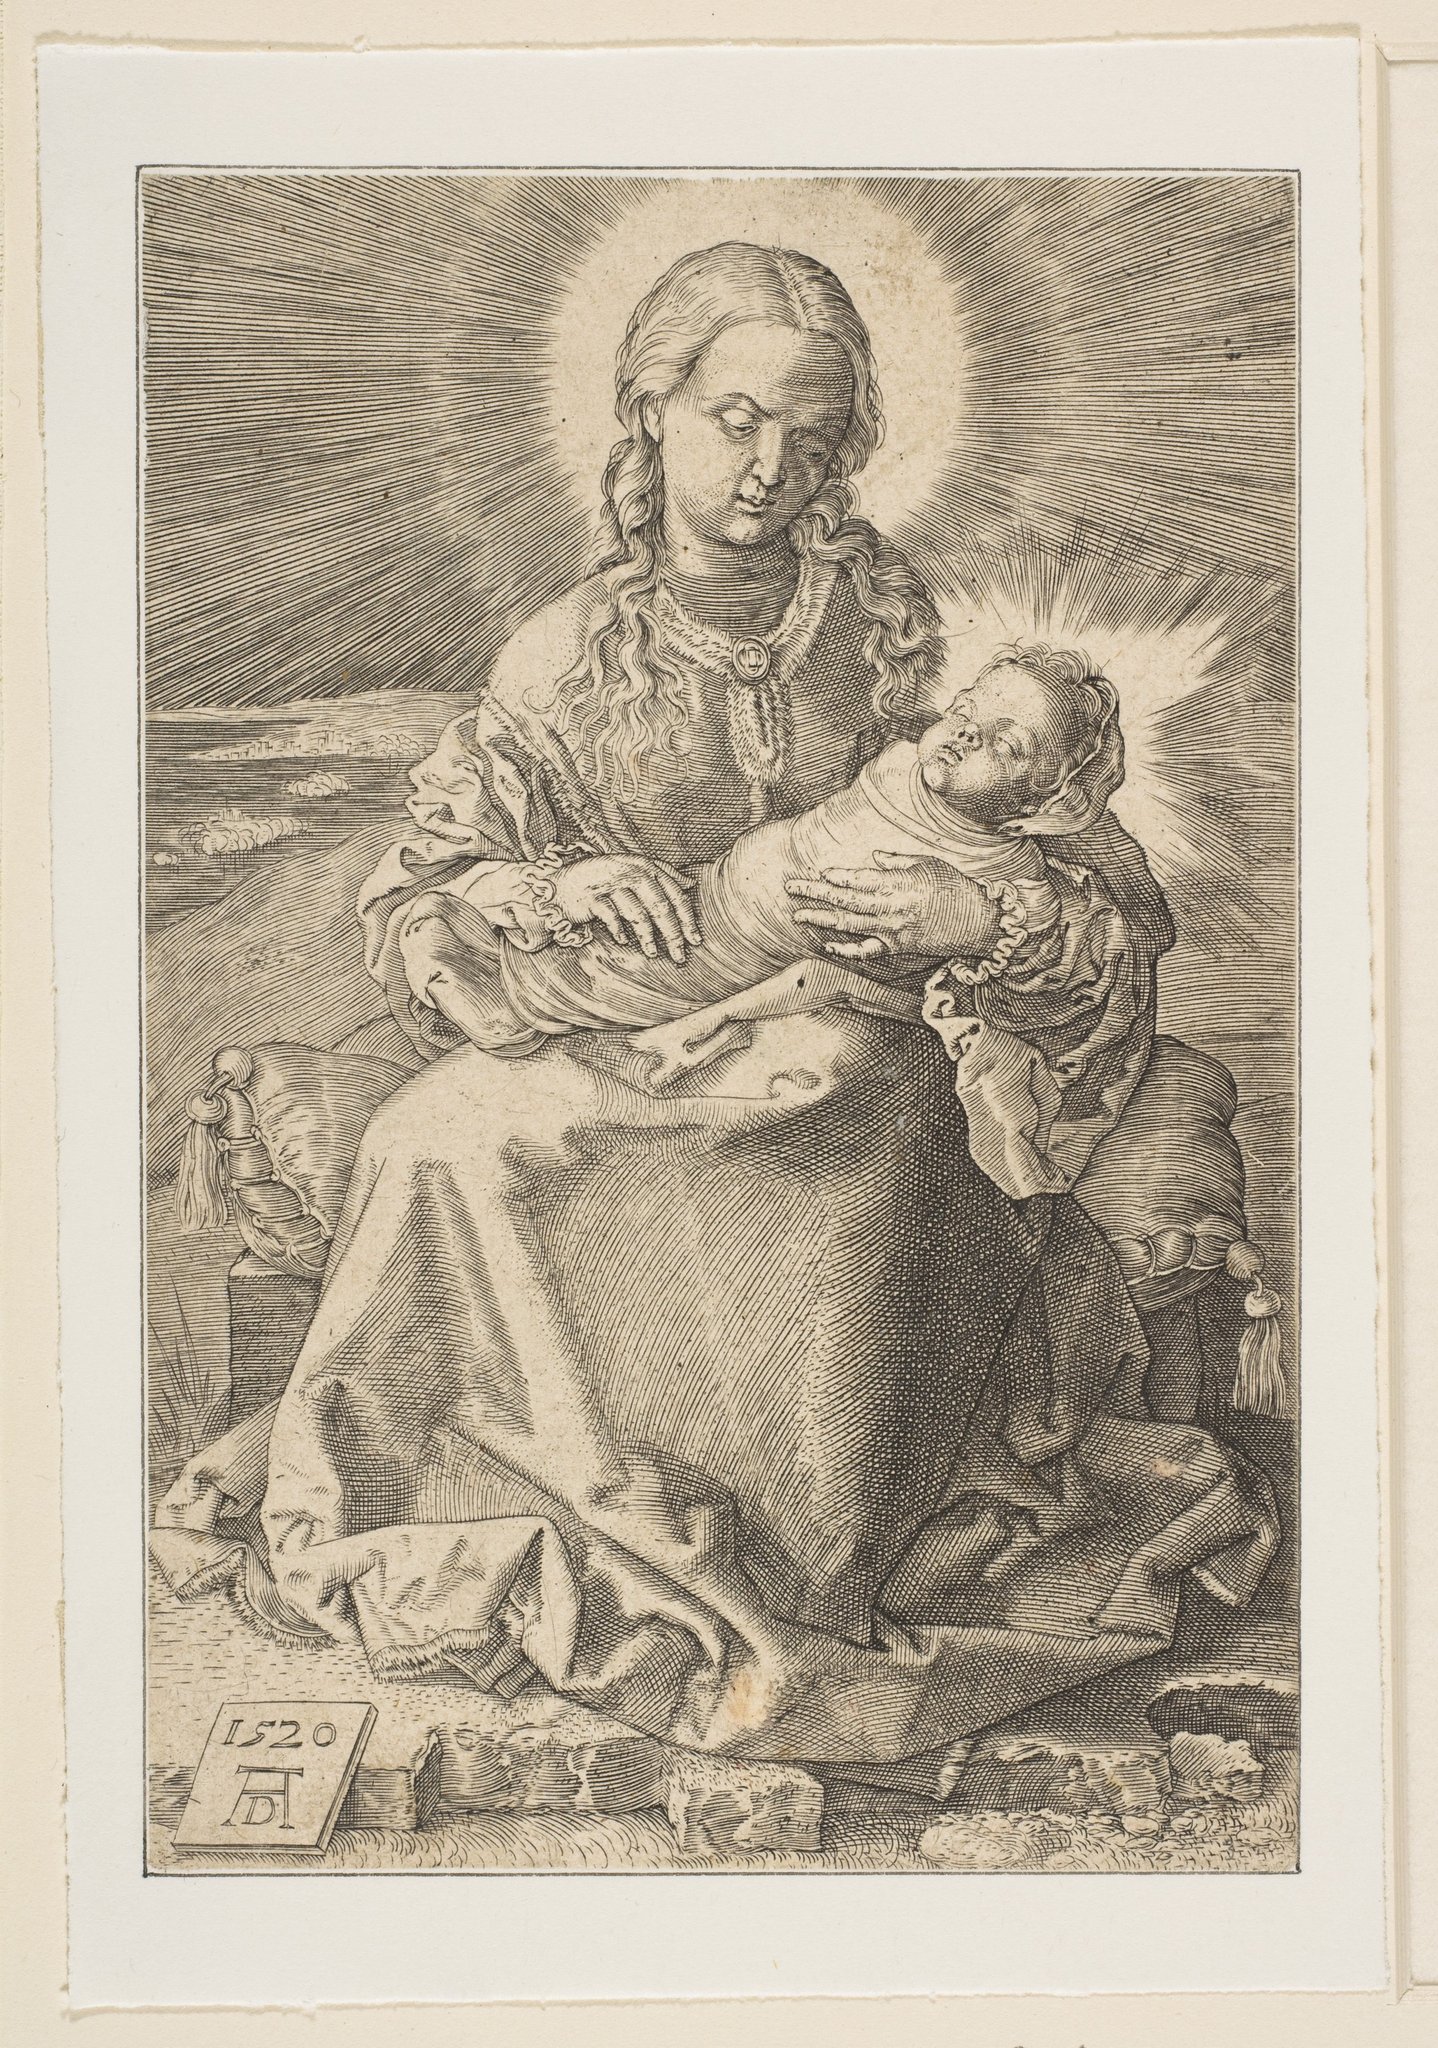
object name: print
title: The Virgin with the Swaddled Child (copy)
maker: albrecht dürer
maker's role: artist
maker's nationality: german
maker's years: 1471-1528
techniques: engraving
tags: madonna and child